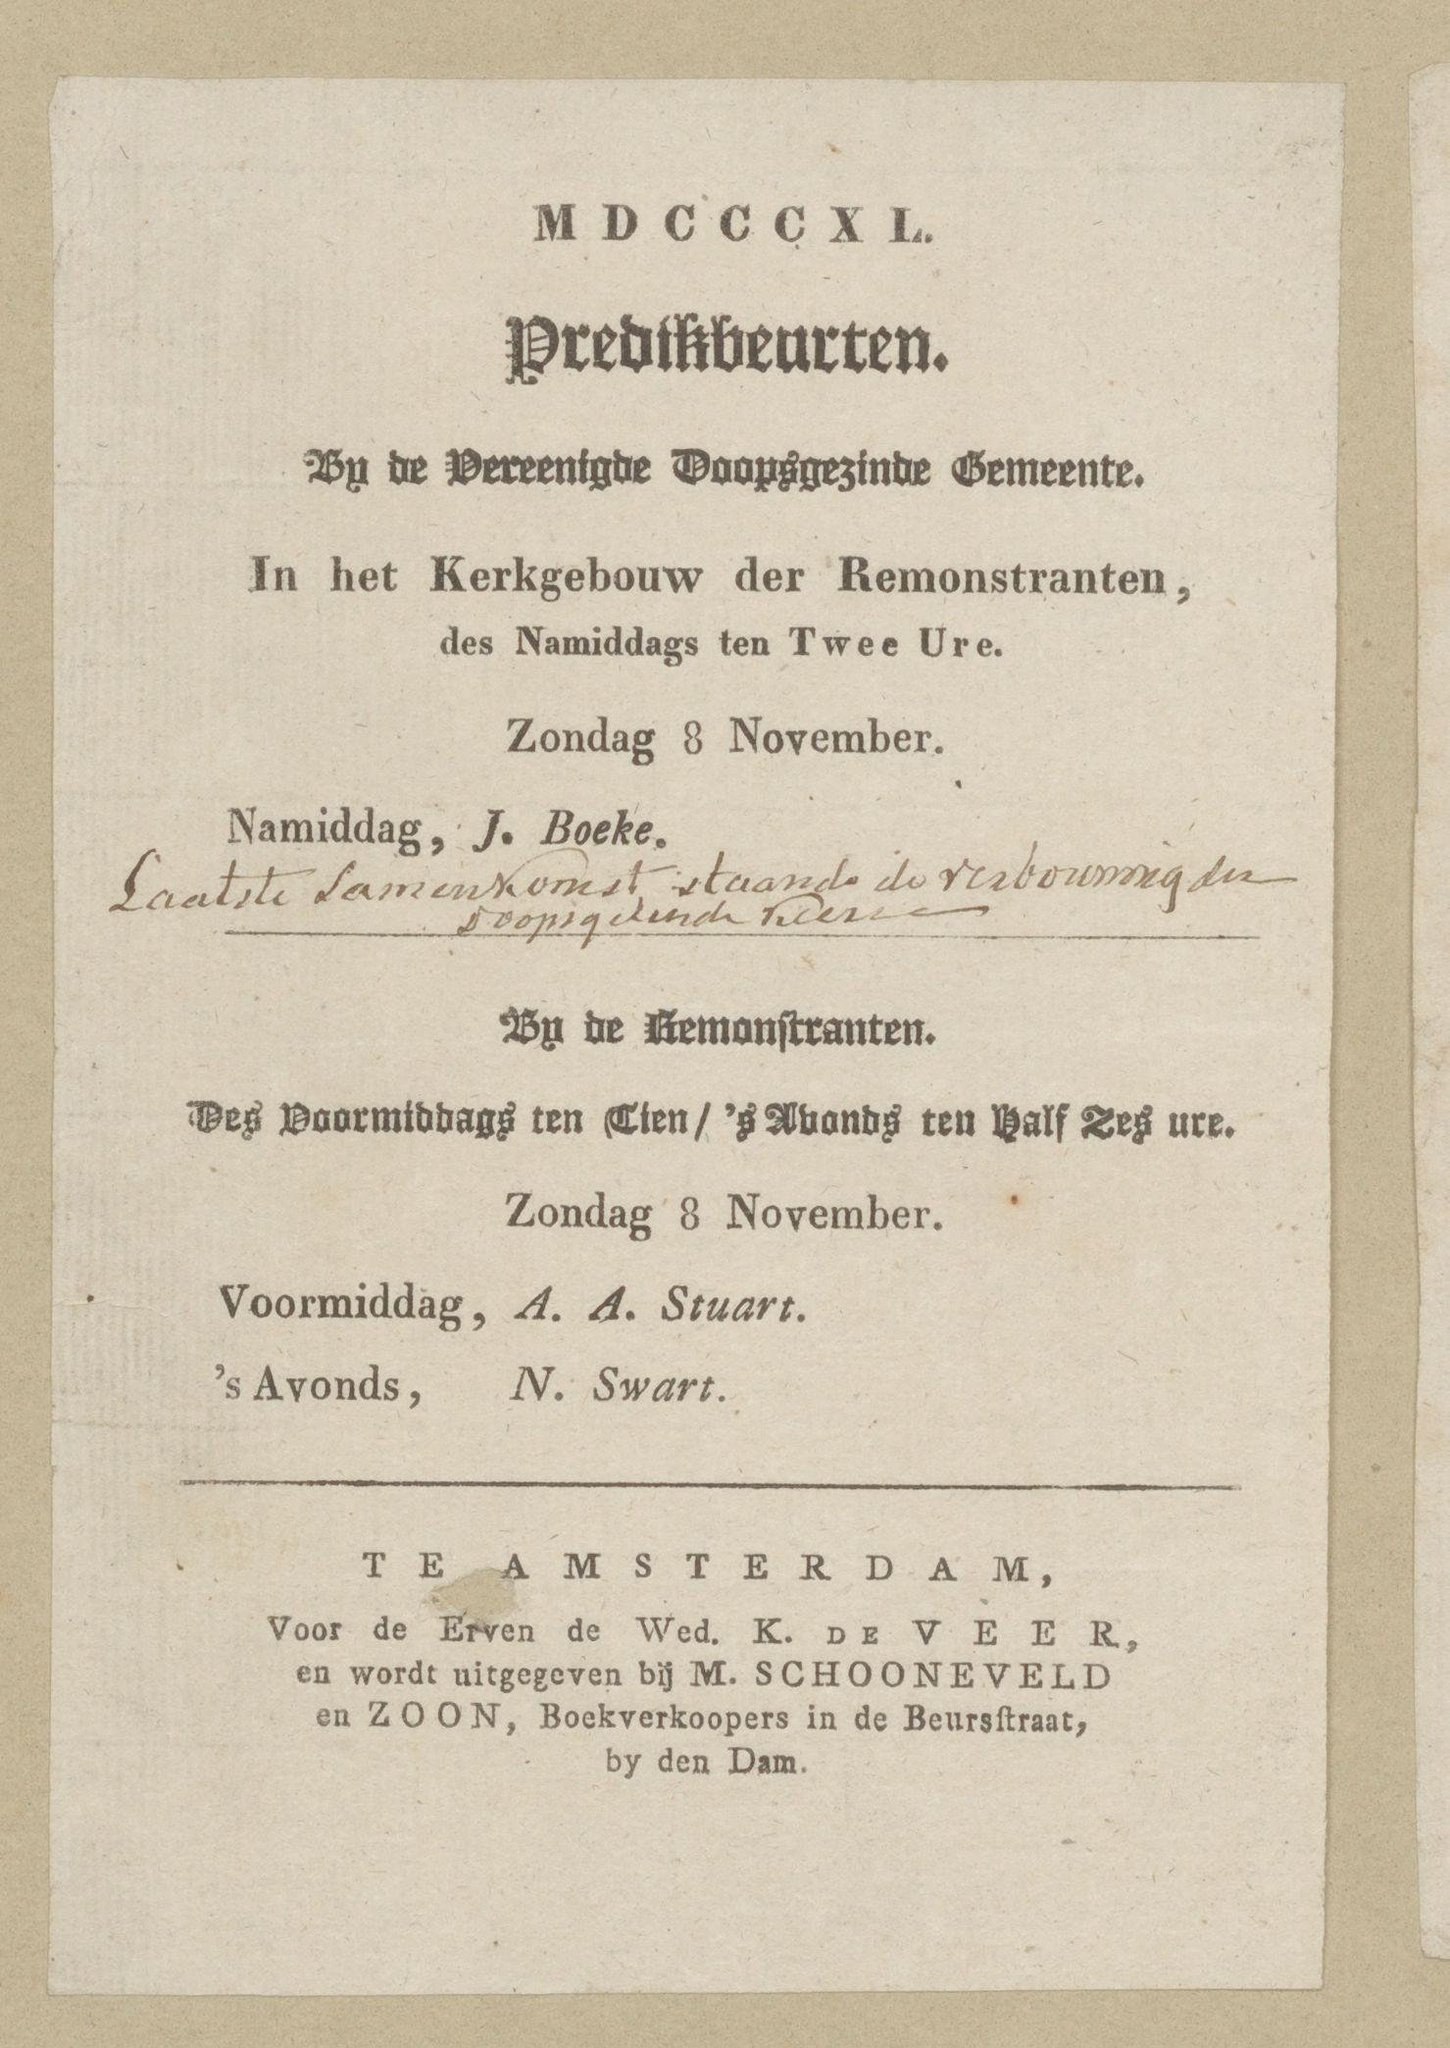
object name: text sheet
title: Lijst met predikbeurten bij de Doopsgezinden en Remonstranten te Amsterdam op 8 november 1840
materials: paper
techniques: letterpress printing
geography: amsterdam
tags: preaching (in general)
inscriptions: collector's mark: Lugt 1641b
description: Onderwerpsrubriek binnen de Atlas Amsterdam: Kerkwezen: Gebouwen diverse gemeenten: Doopsgezinde predikanten.